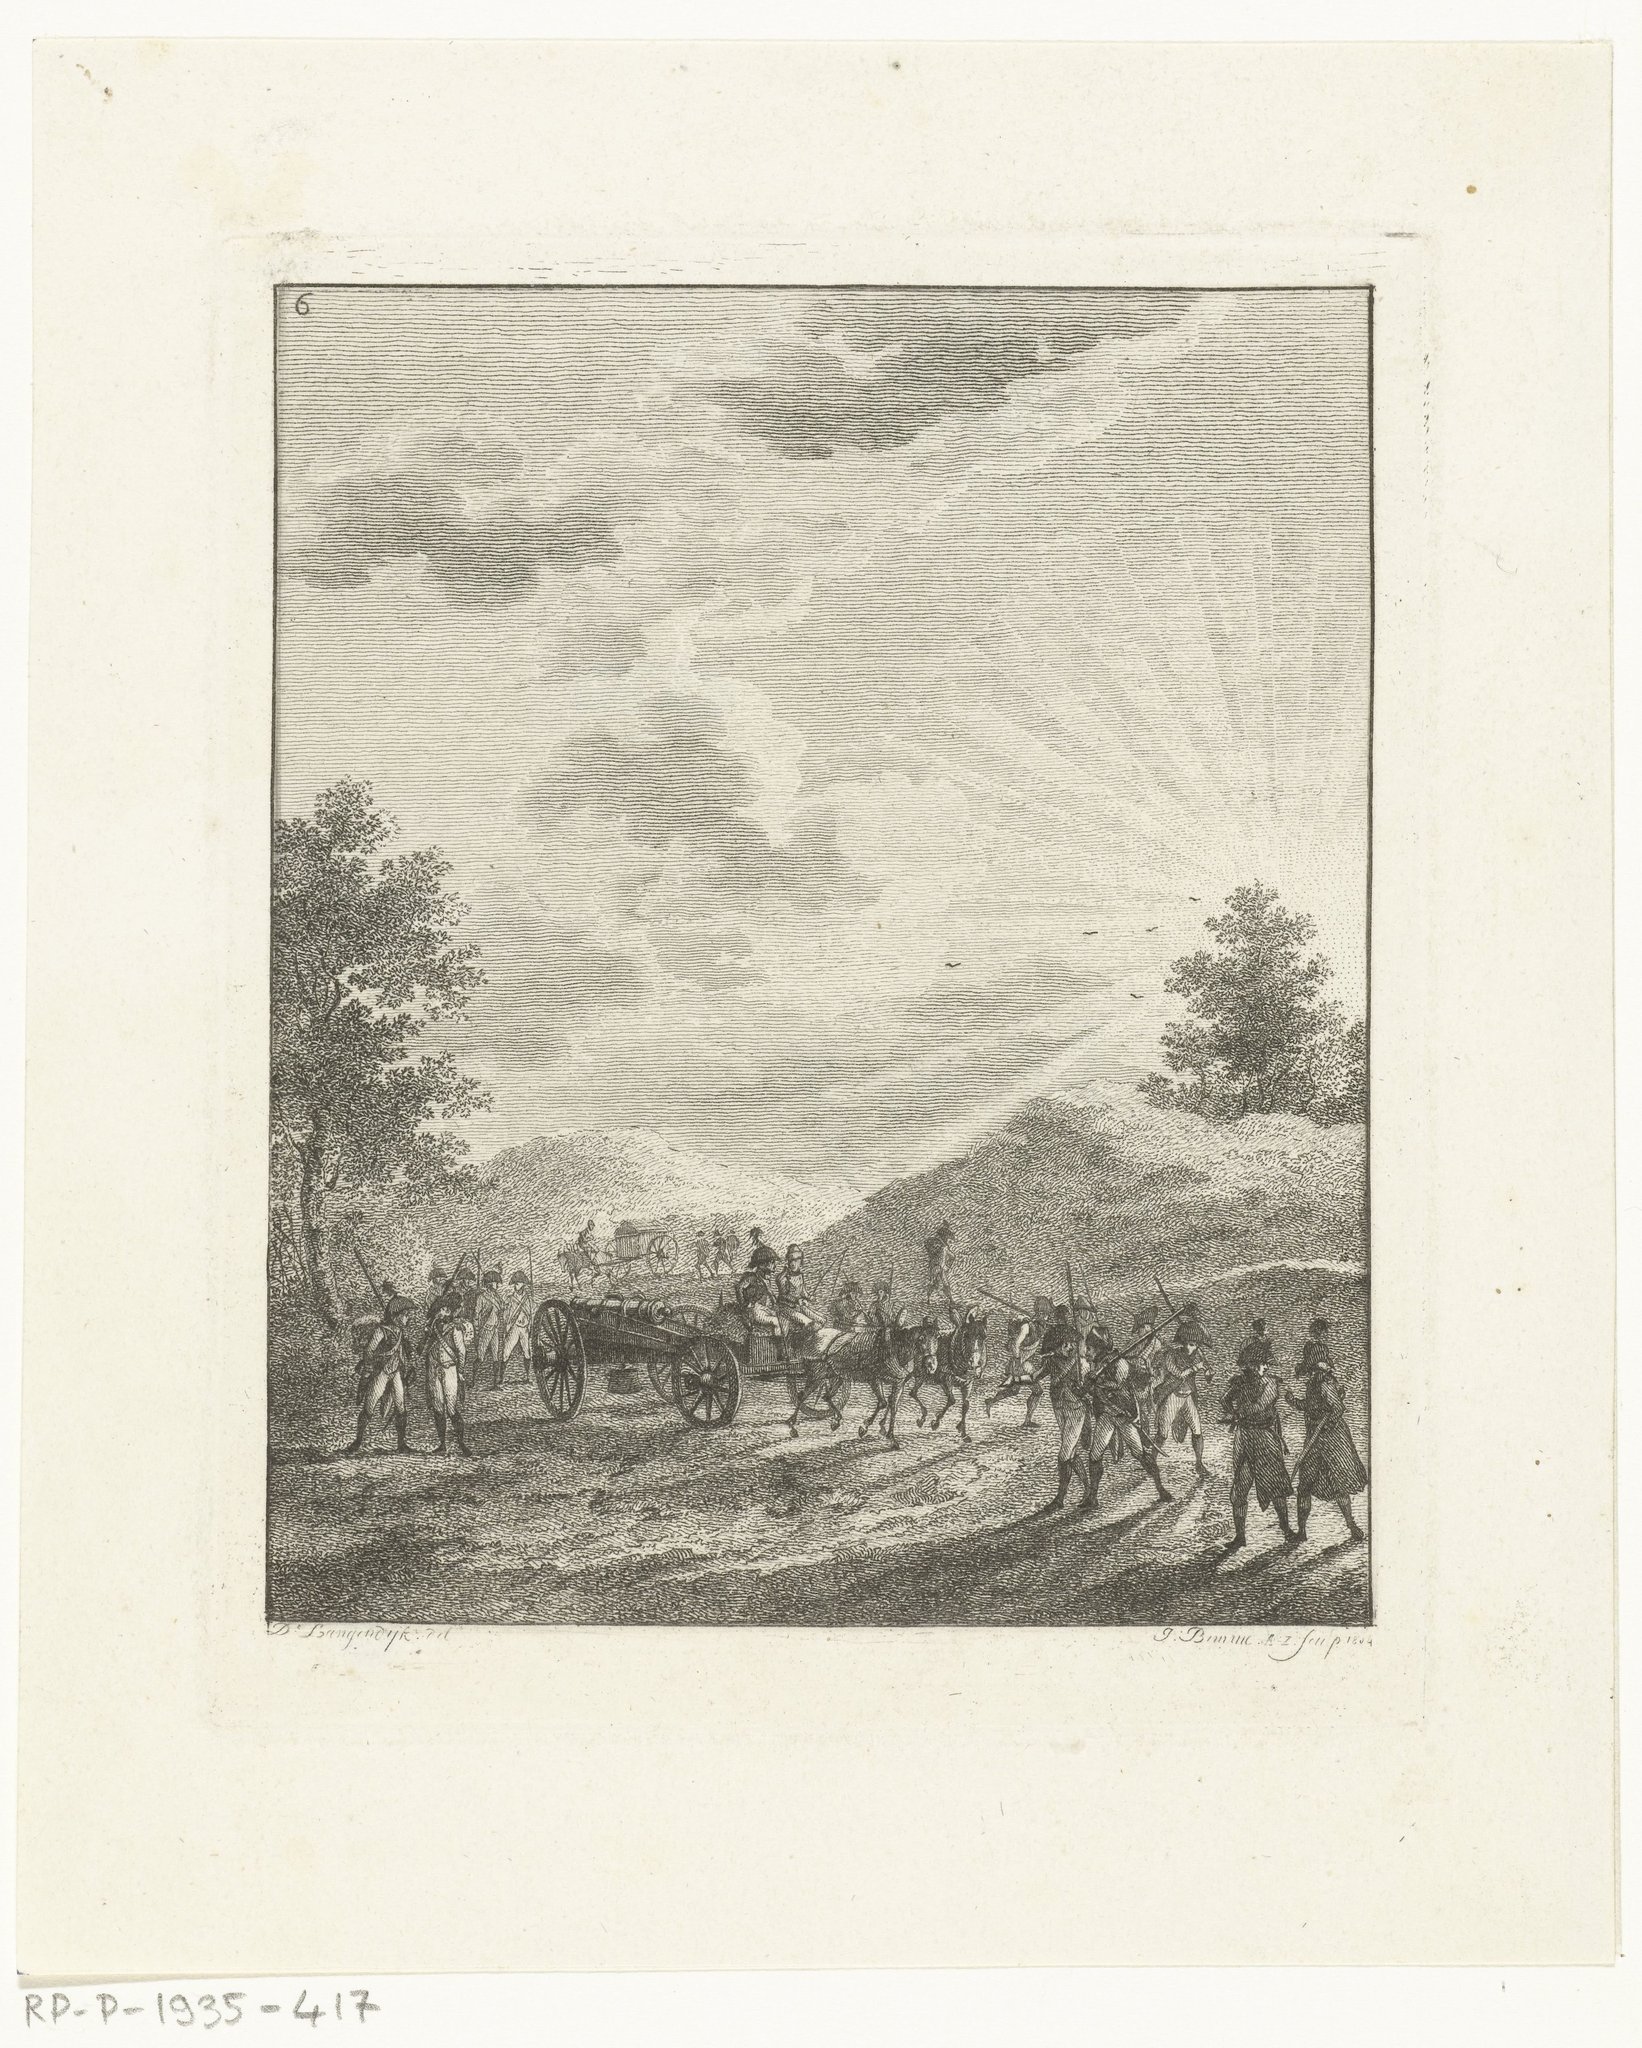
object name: print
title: Infanteristen in een zonovergoten landschap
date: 1804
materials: paper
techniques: etching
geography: rotterdam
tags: warfare; military affairs (+ infantry)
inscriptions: collector's mark: Lugt 1377, collector's mark: Lugt 2228, collector's mark: Lugt 2228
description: Infanteristen lopen in een zonovergoten landschap. Tussen hen in wagens met kanonnen en munitie.